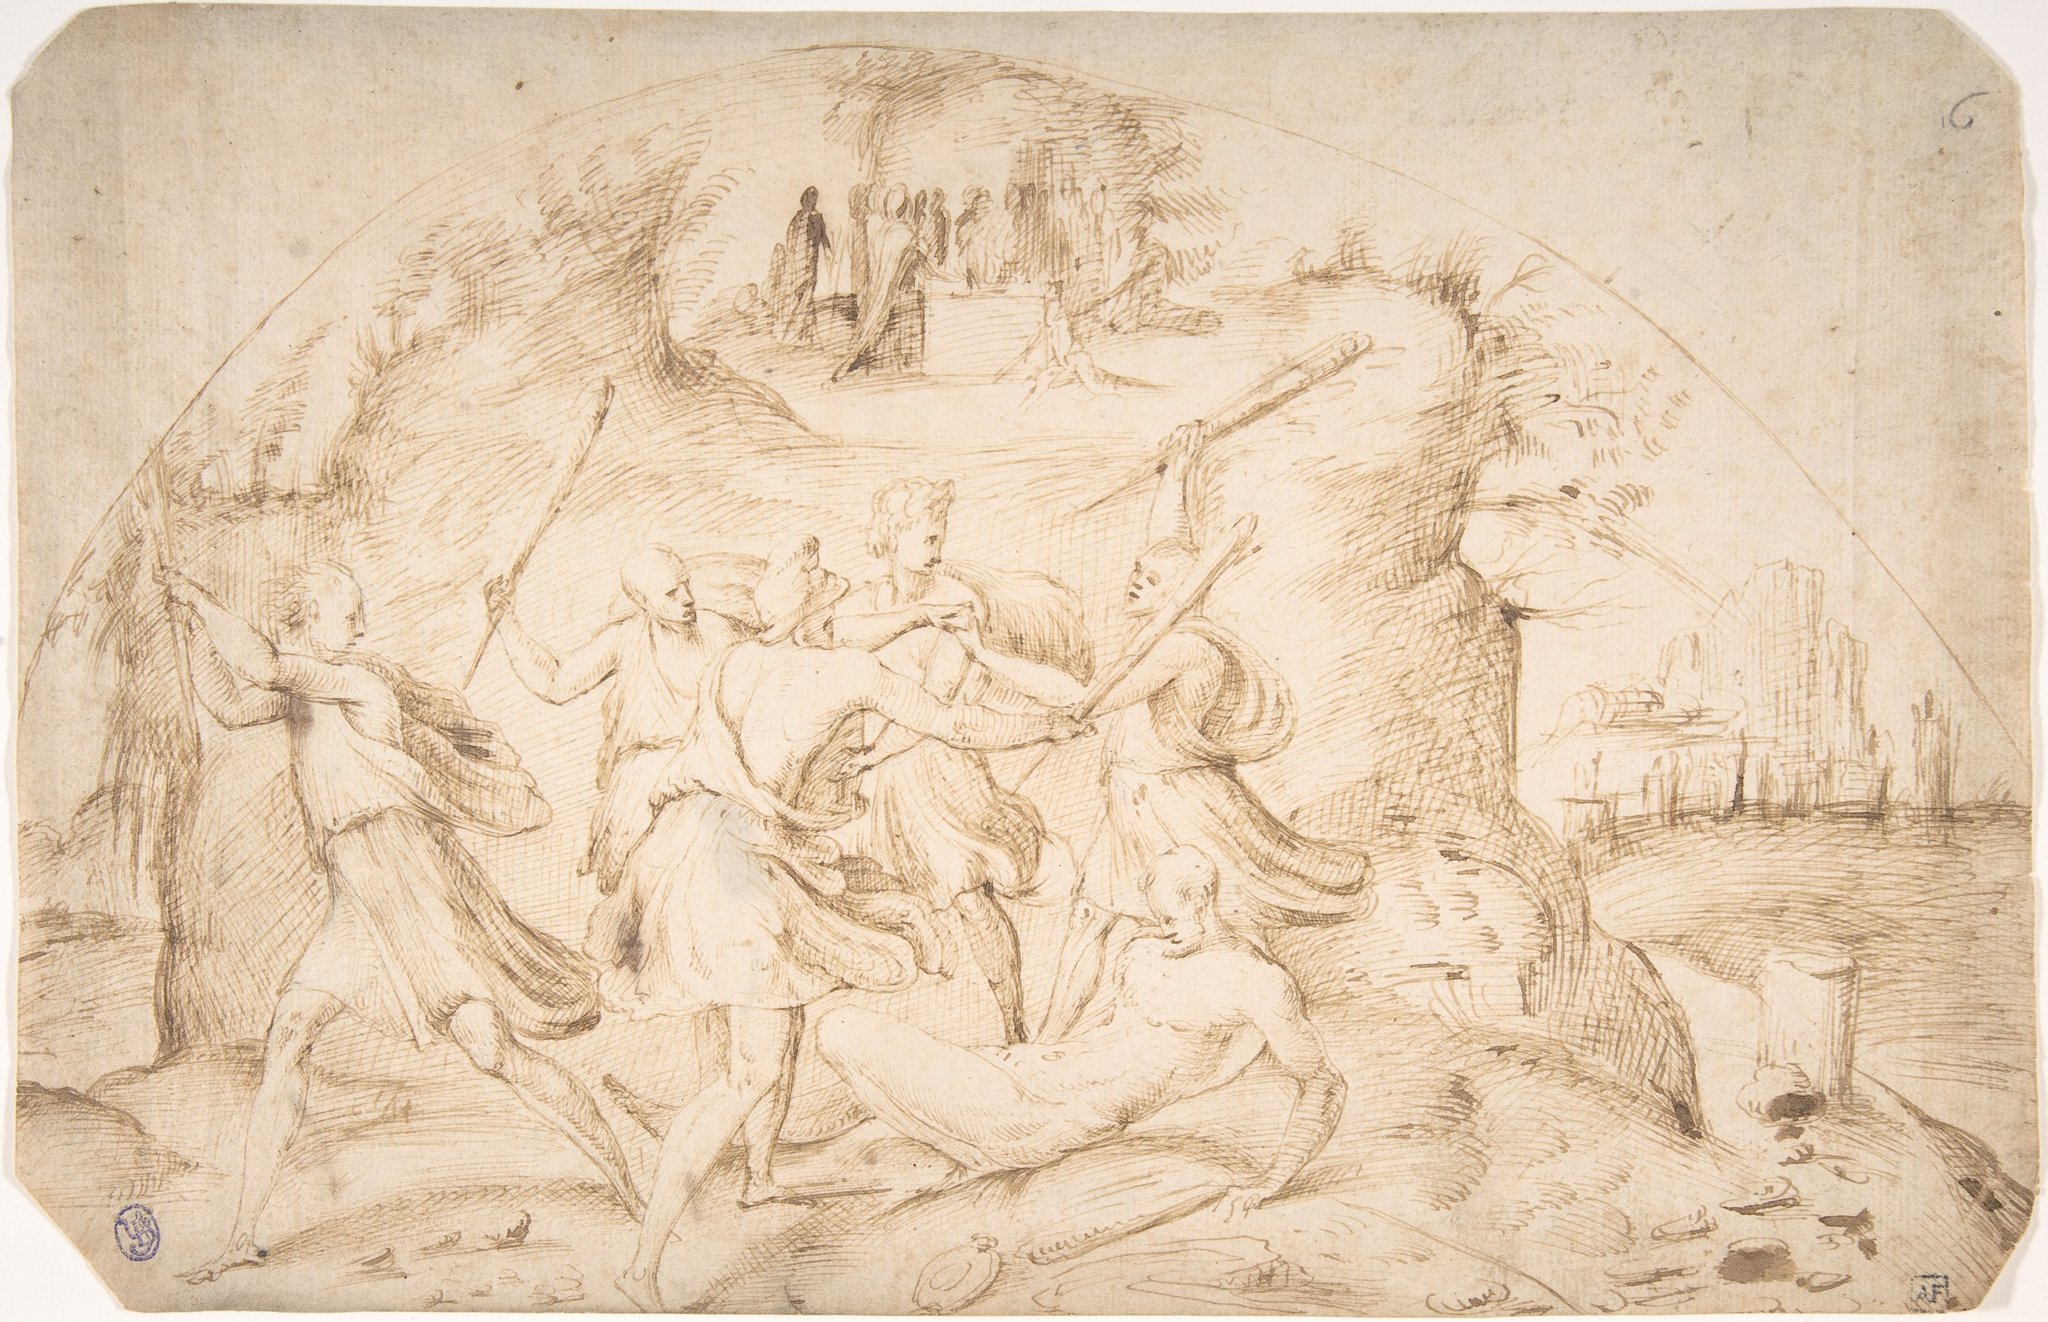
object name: drawing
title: The Age of Iron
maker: alonso berruguete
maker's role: artist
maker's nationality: spanish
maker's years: 1488-1561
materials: ink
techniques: pen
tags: human figures